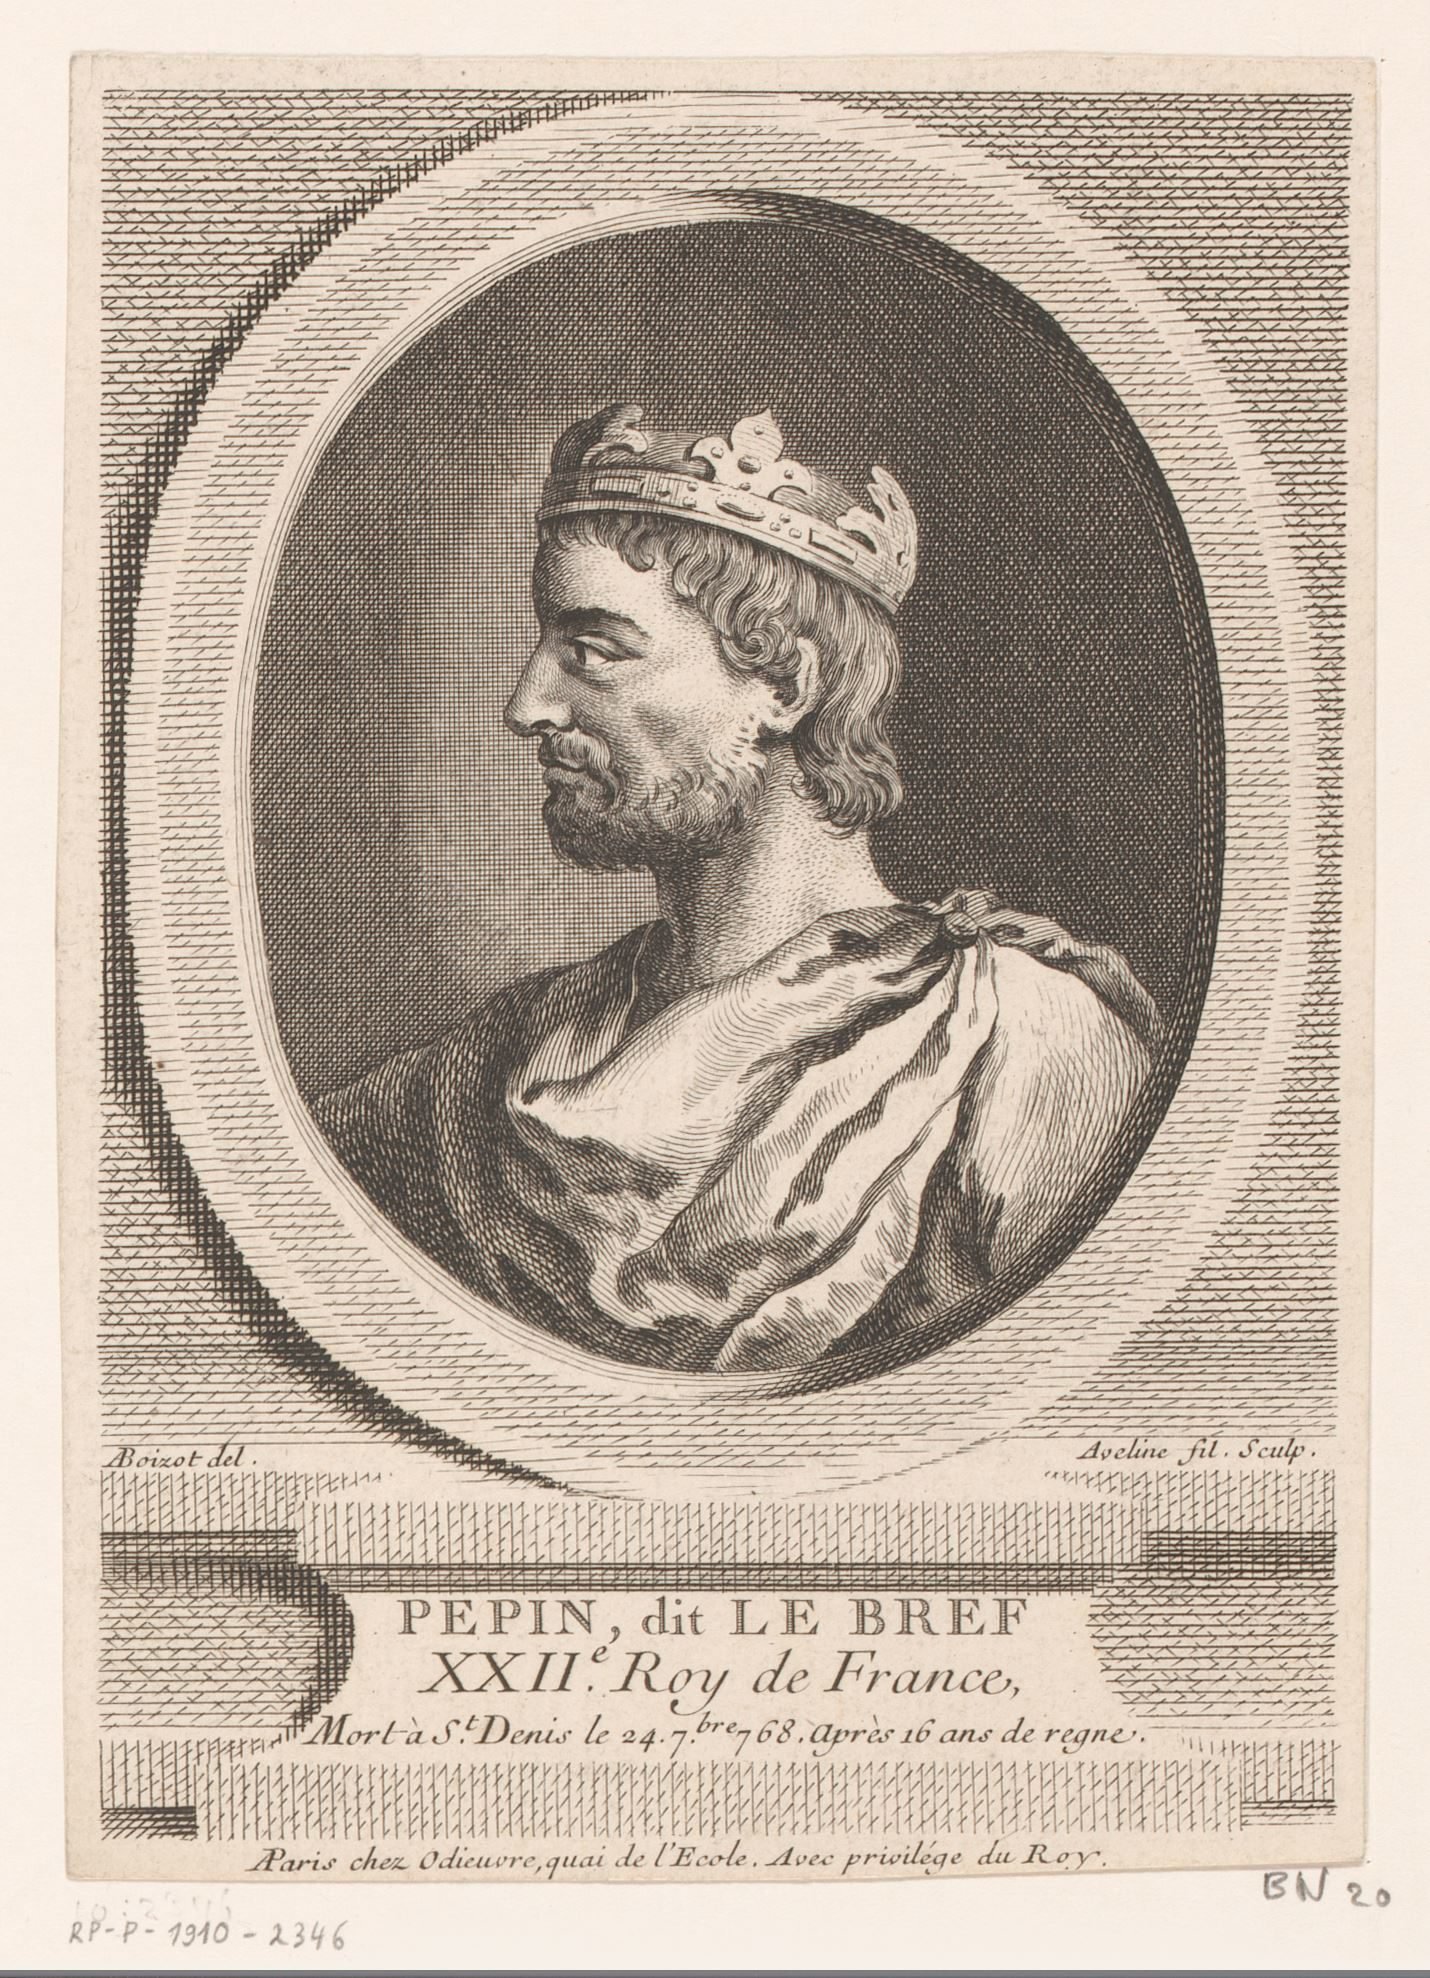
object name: print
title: Portret van Pepijn de Korte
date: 1755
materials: paper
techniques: engraving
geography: paris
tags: liège, ornament ~ medallion, historical persons, ruler, sovereign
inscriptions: collector's mark: Lugt 2228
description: Prent uit: Dreux du Radier, Jean-François. L'Europe illustré, contenant l'histoire abregée des souverains, des princes, des prélats, des ministres, (...) en Europe: dans le XVe. siècle compris, jusqu'à présent. Parijs: Michel Odieuvre en André-François Le Breton, 1755, dl. 1.